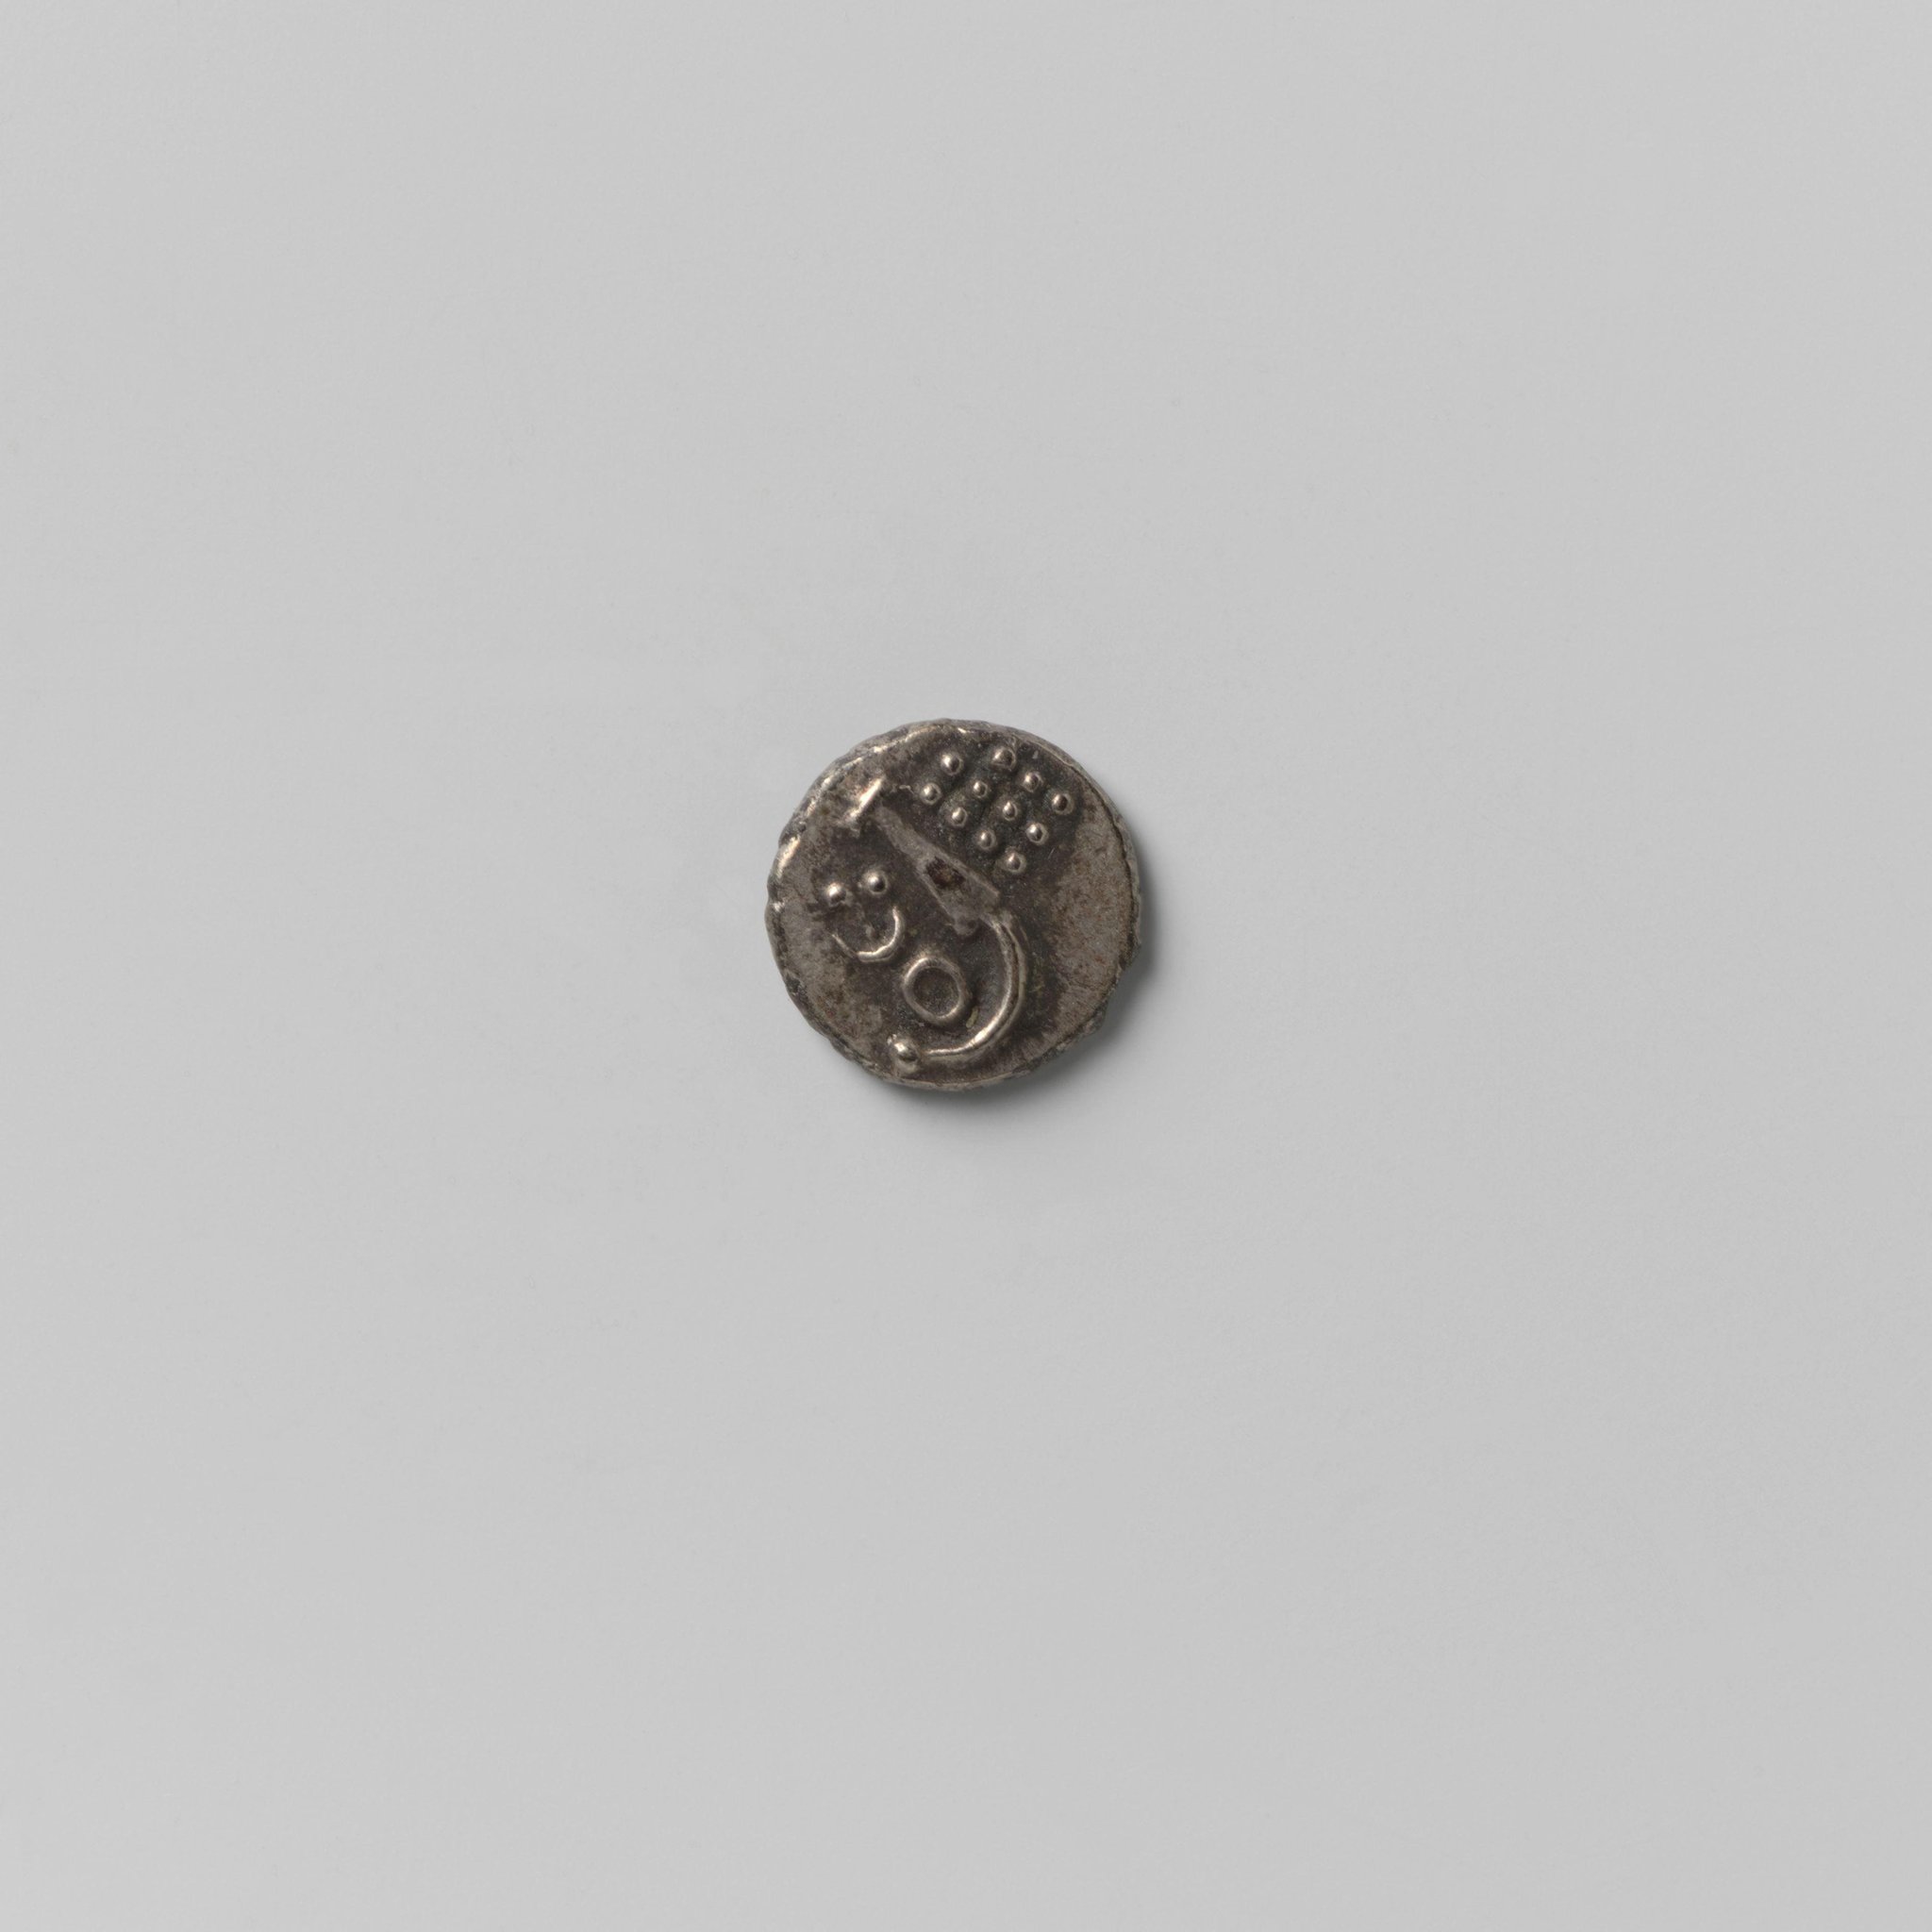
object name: coin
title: Zilveren fanam van Cochin, Voor-Indië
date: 1782-1783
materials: silver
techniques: striking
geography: kochi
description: Zilveren munt. Voorzijde: Kali-figuur met op de borst 12 punten in drie rijen van vier. Keerzijde: liggende J, daarboven OC en onderaan twaalf punten in drie rijen van vier. Gladde rand.